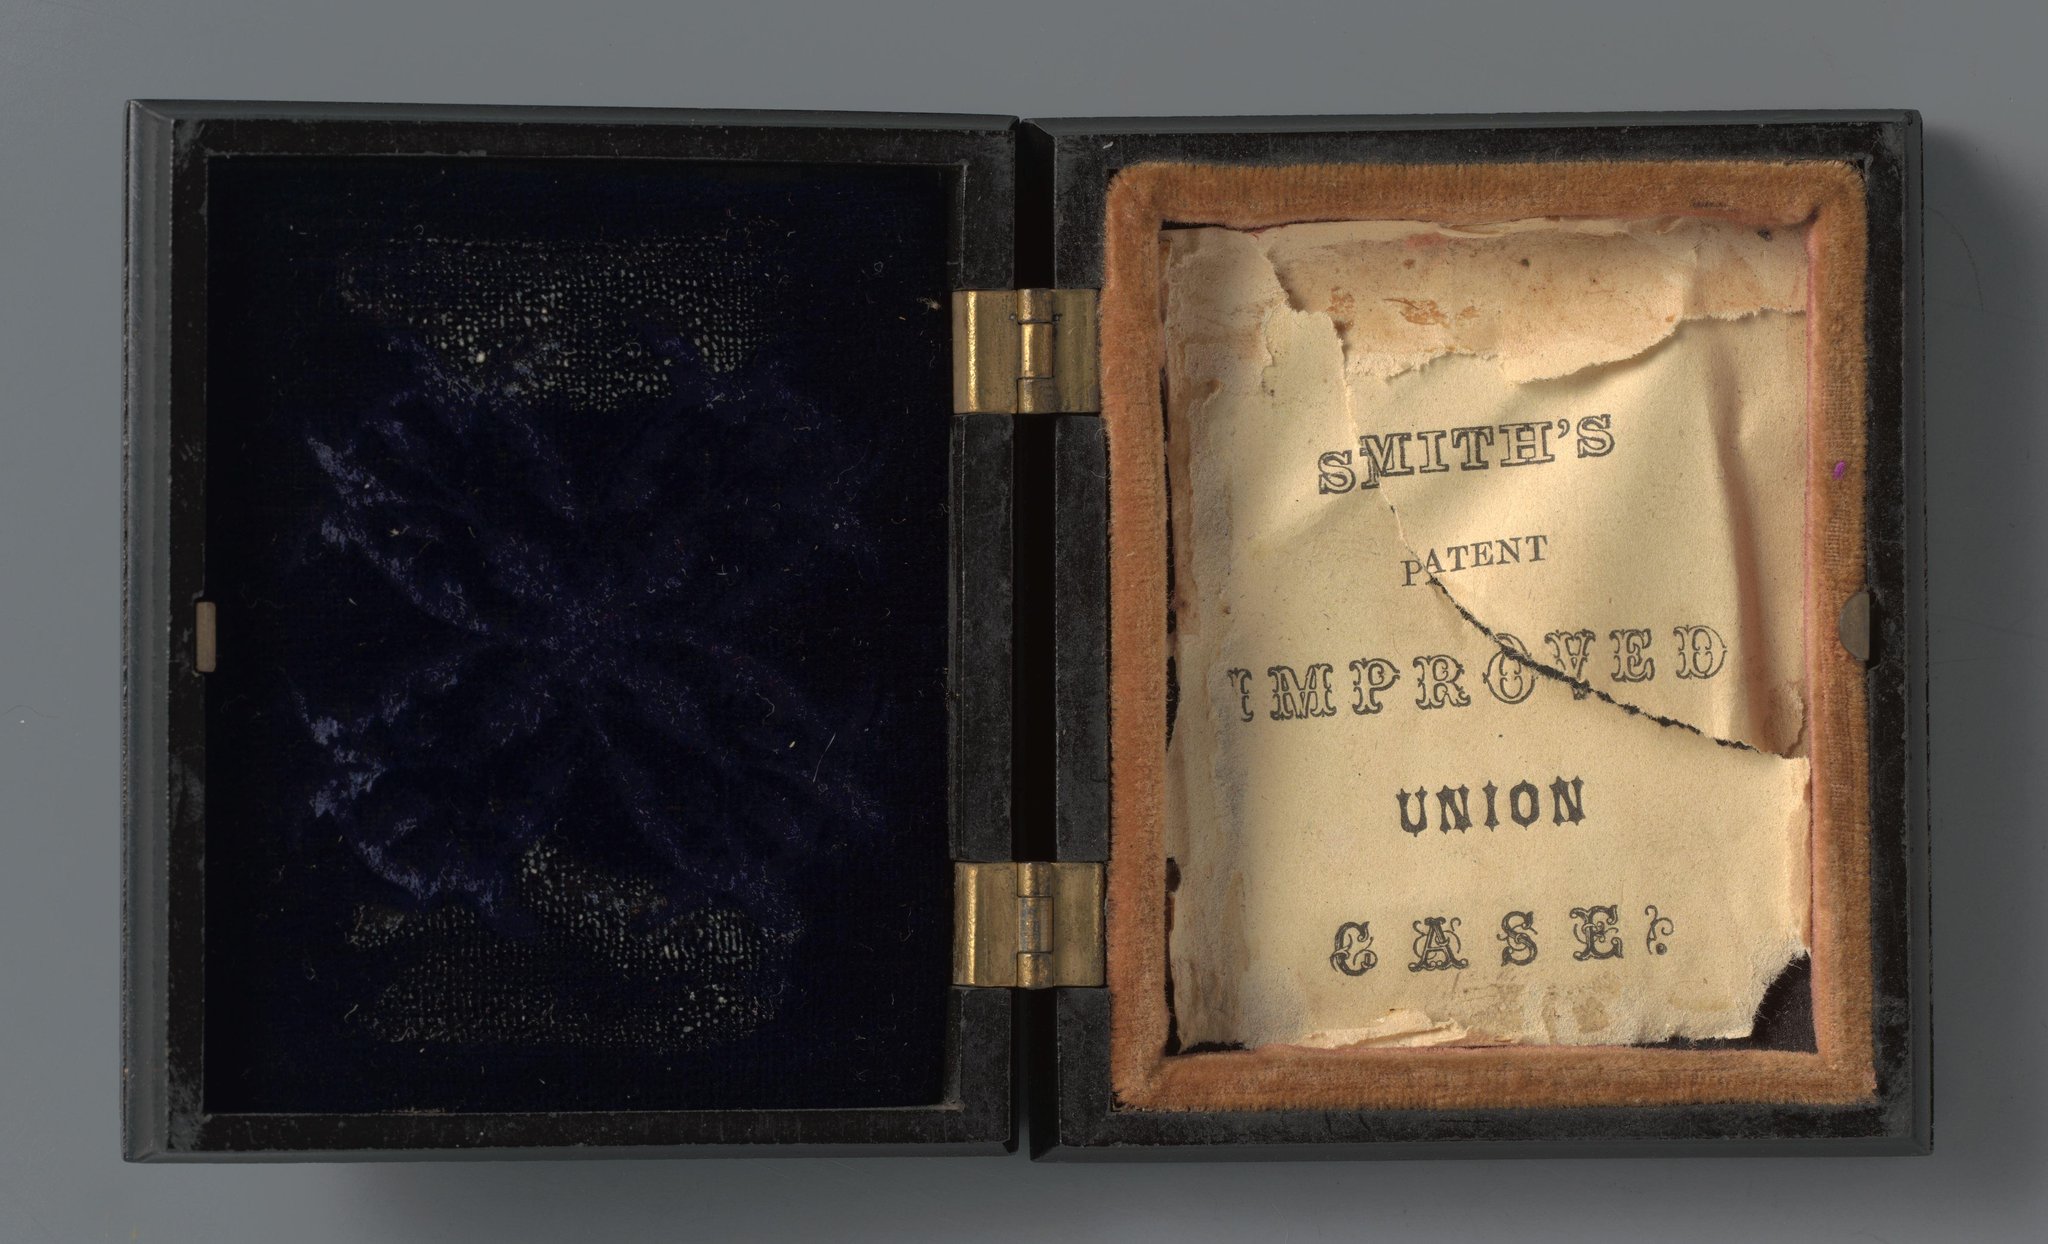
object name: photograph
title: Union case (leeg)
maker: s. smith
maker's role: fotograaf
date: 1855-1870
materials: metal, velvet, wood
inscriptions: inscription: ‘SMITH'S/ PATENT/ IMPROVED/ UNION/ CASE’